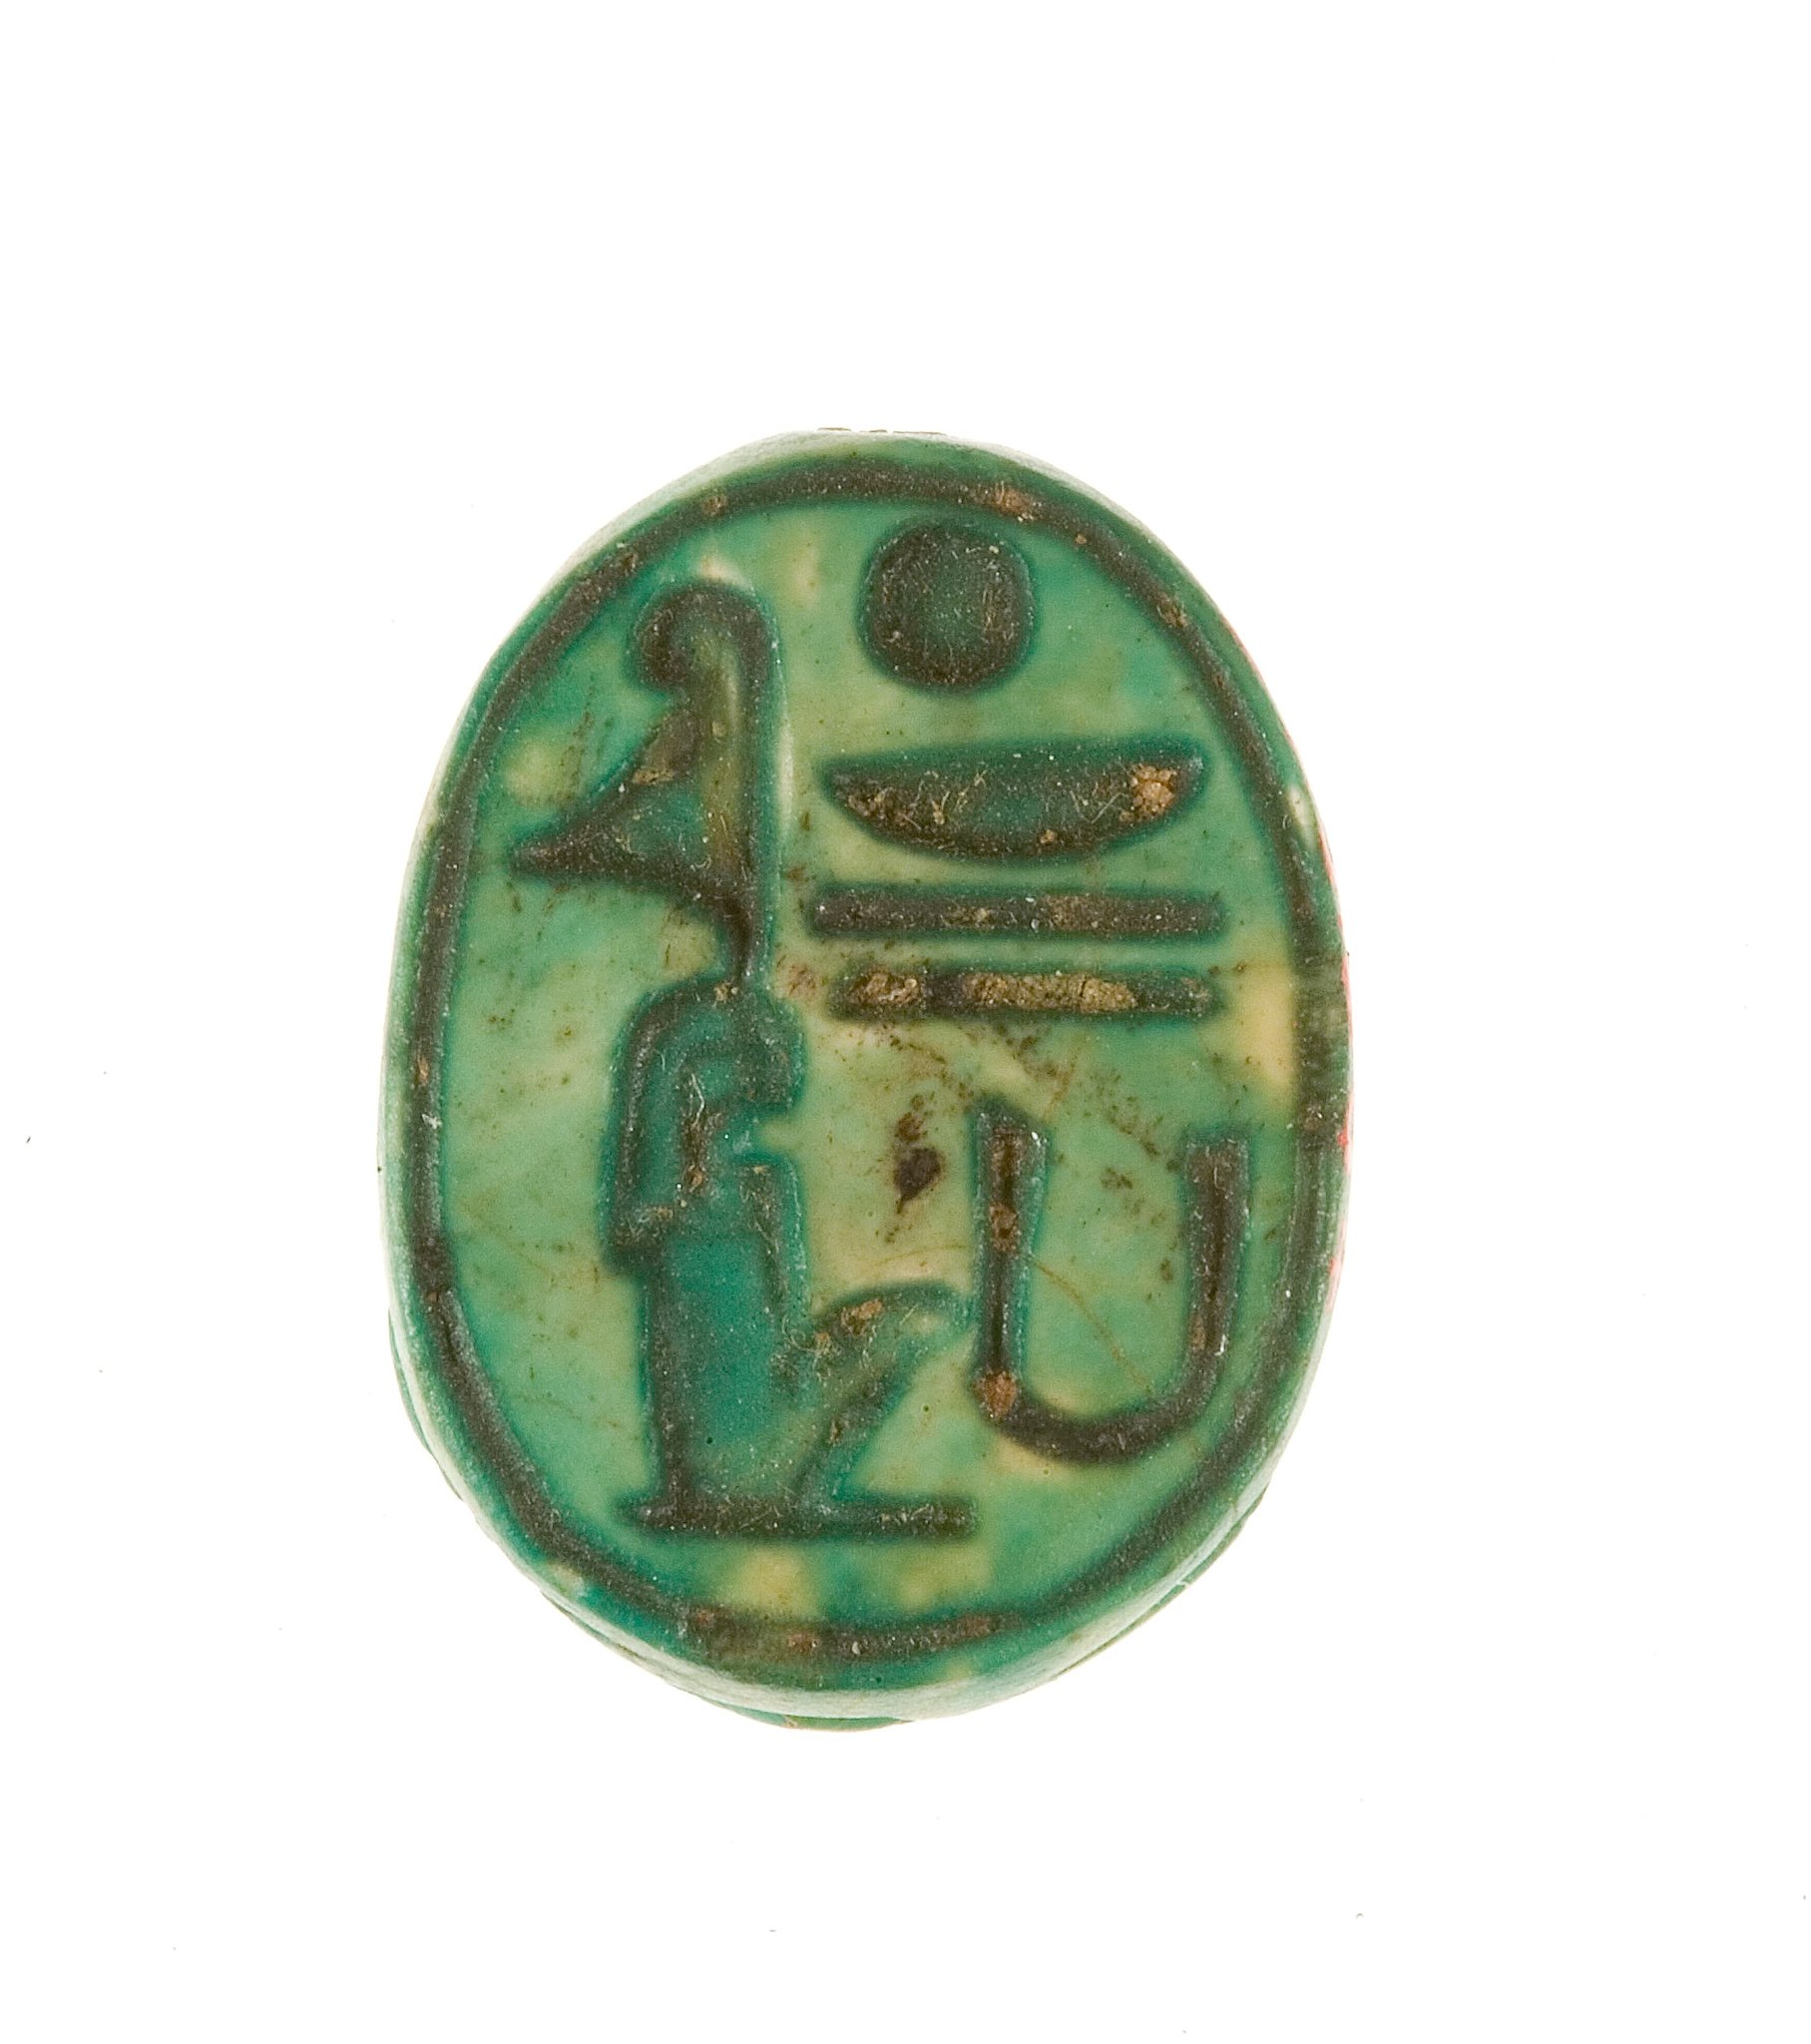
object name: scarab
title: Scarab Inscribed Lord of the Two Lands Maatkare (Hatshepsut)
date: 1479-1458 BCE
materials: stone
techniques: glazing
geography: egypt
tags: hieroglyphs,scarabs